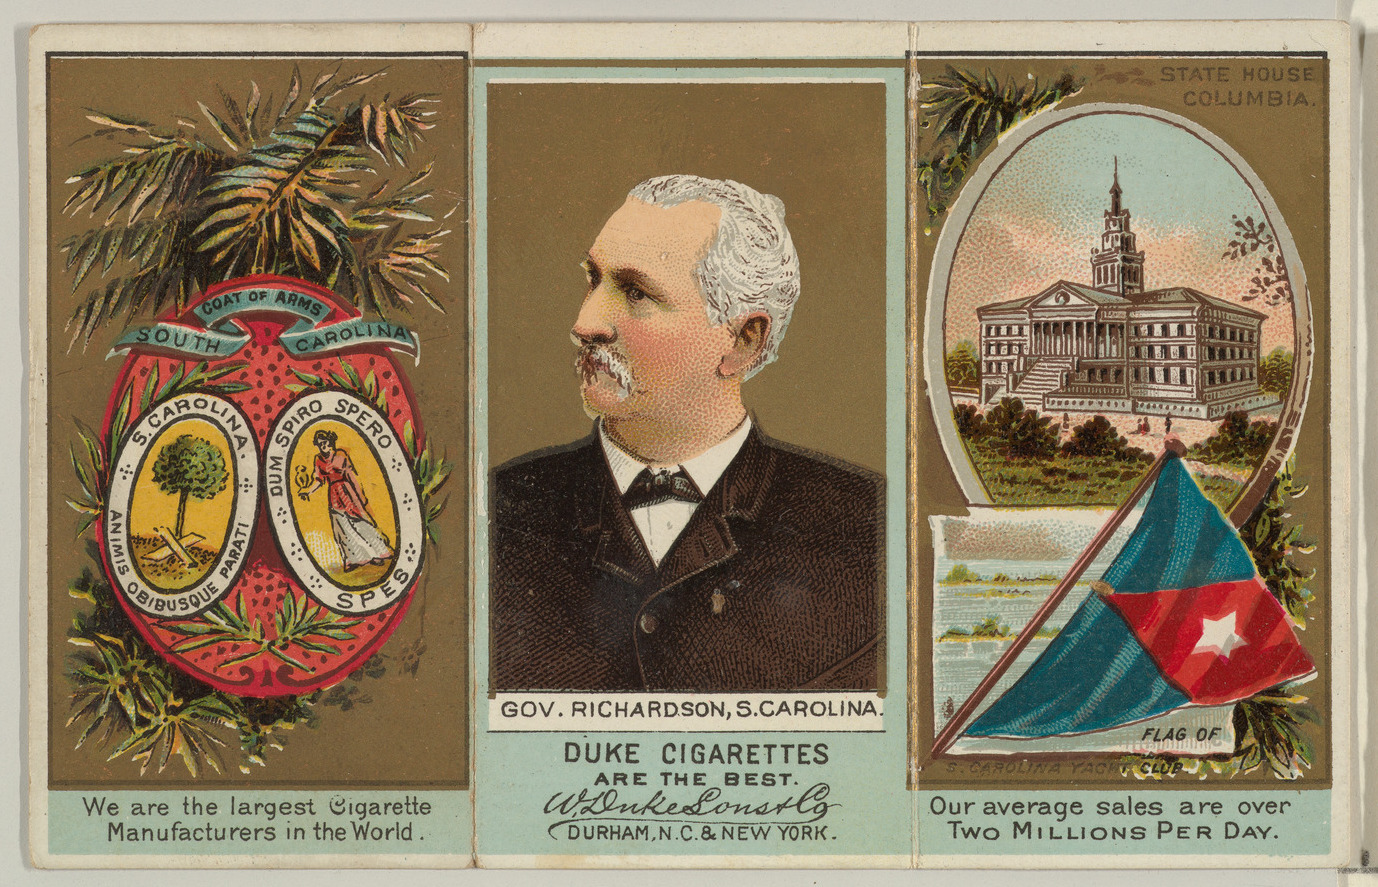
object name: print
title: Governor Richardson, South Carolina, from "Governors, Arms, Etc." series (N133-2), issued by Duke Sons & Co.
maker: w. duke, sons & co.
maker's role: publisher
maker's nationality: american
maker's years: 1870-1920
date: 1888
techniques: color lithograph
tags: buildings,men,profiles,coat of arms,flags